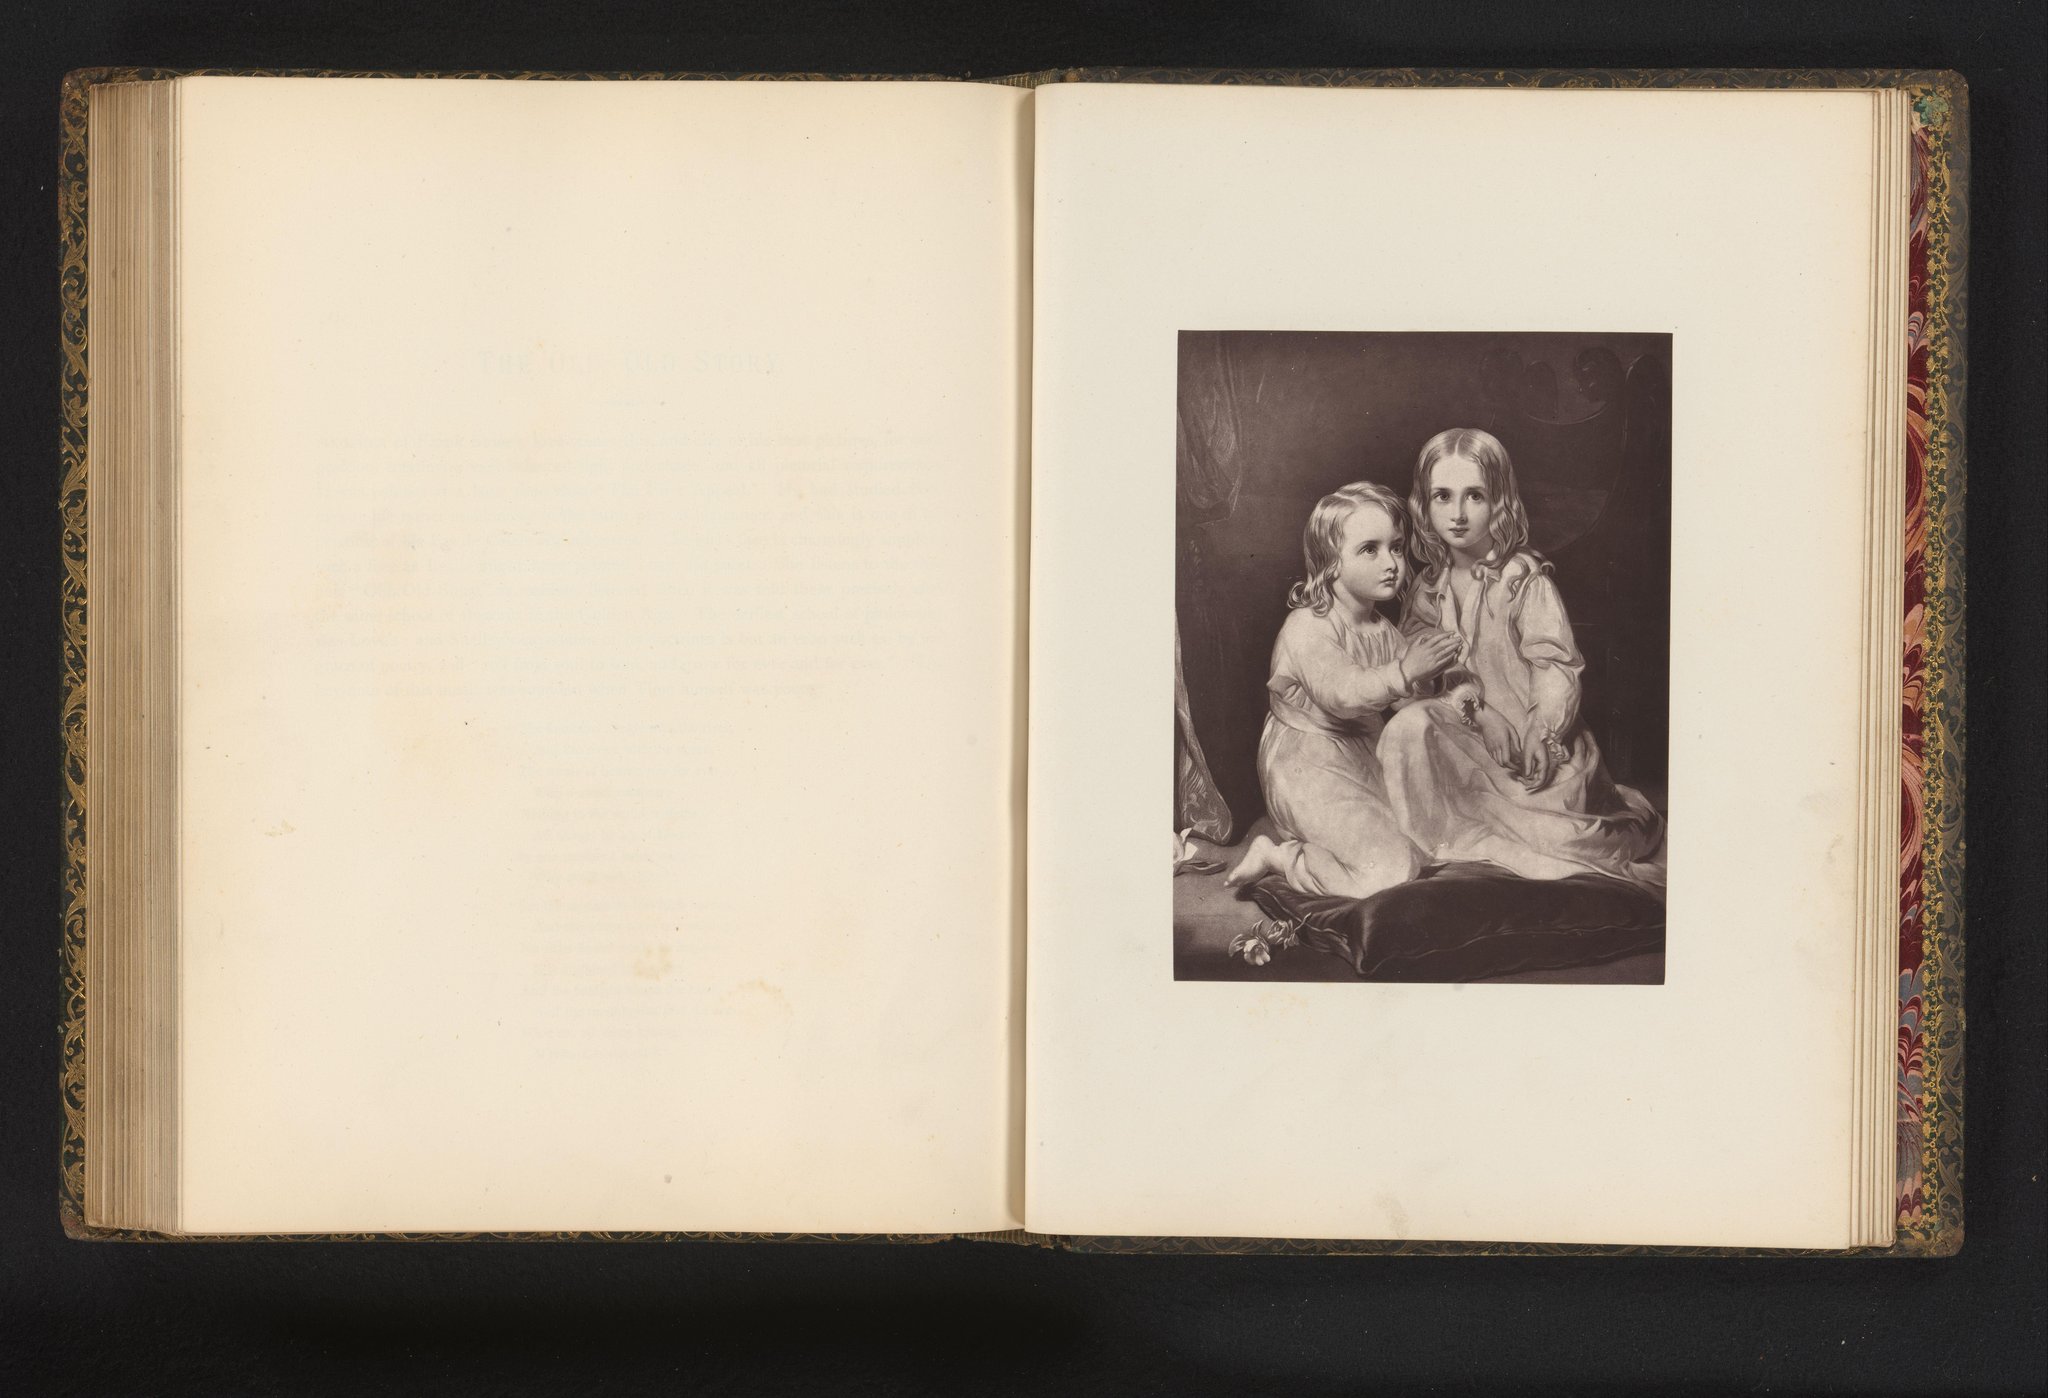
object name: page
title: Fotoreproductie van een gravure naar een schilderij van twee biddende meisjes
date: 1866-1871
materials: paper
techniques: woodburytype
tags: print, e.g.: engraving, etching, lithograph, (private) prayer; 'oratione', 'preghiere', 'preghiere a dio' (ripa)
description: Prent op derde ongenummerde pagina na pagina 120.